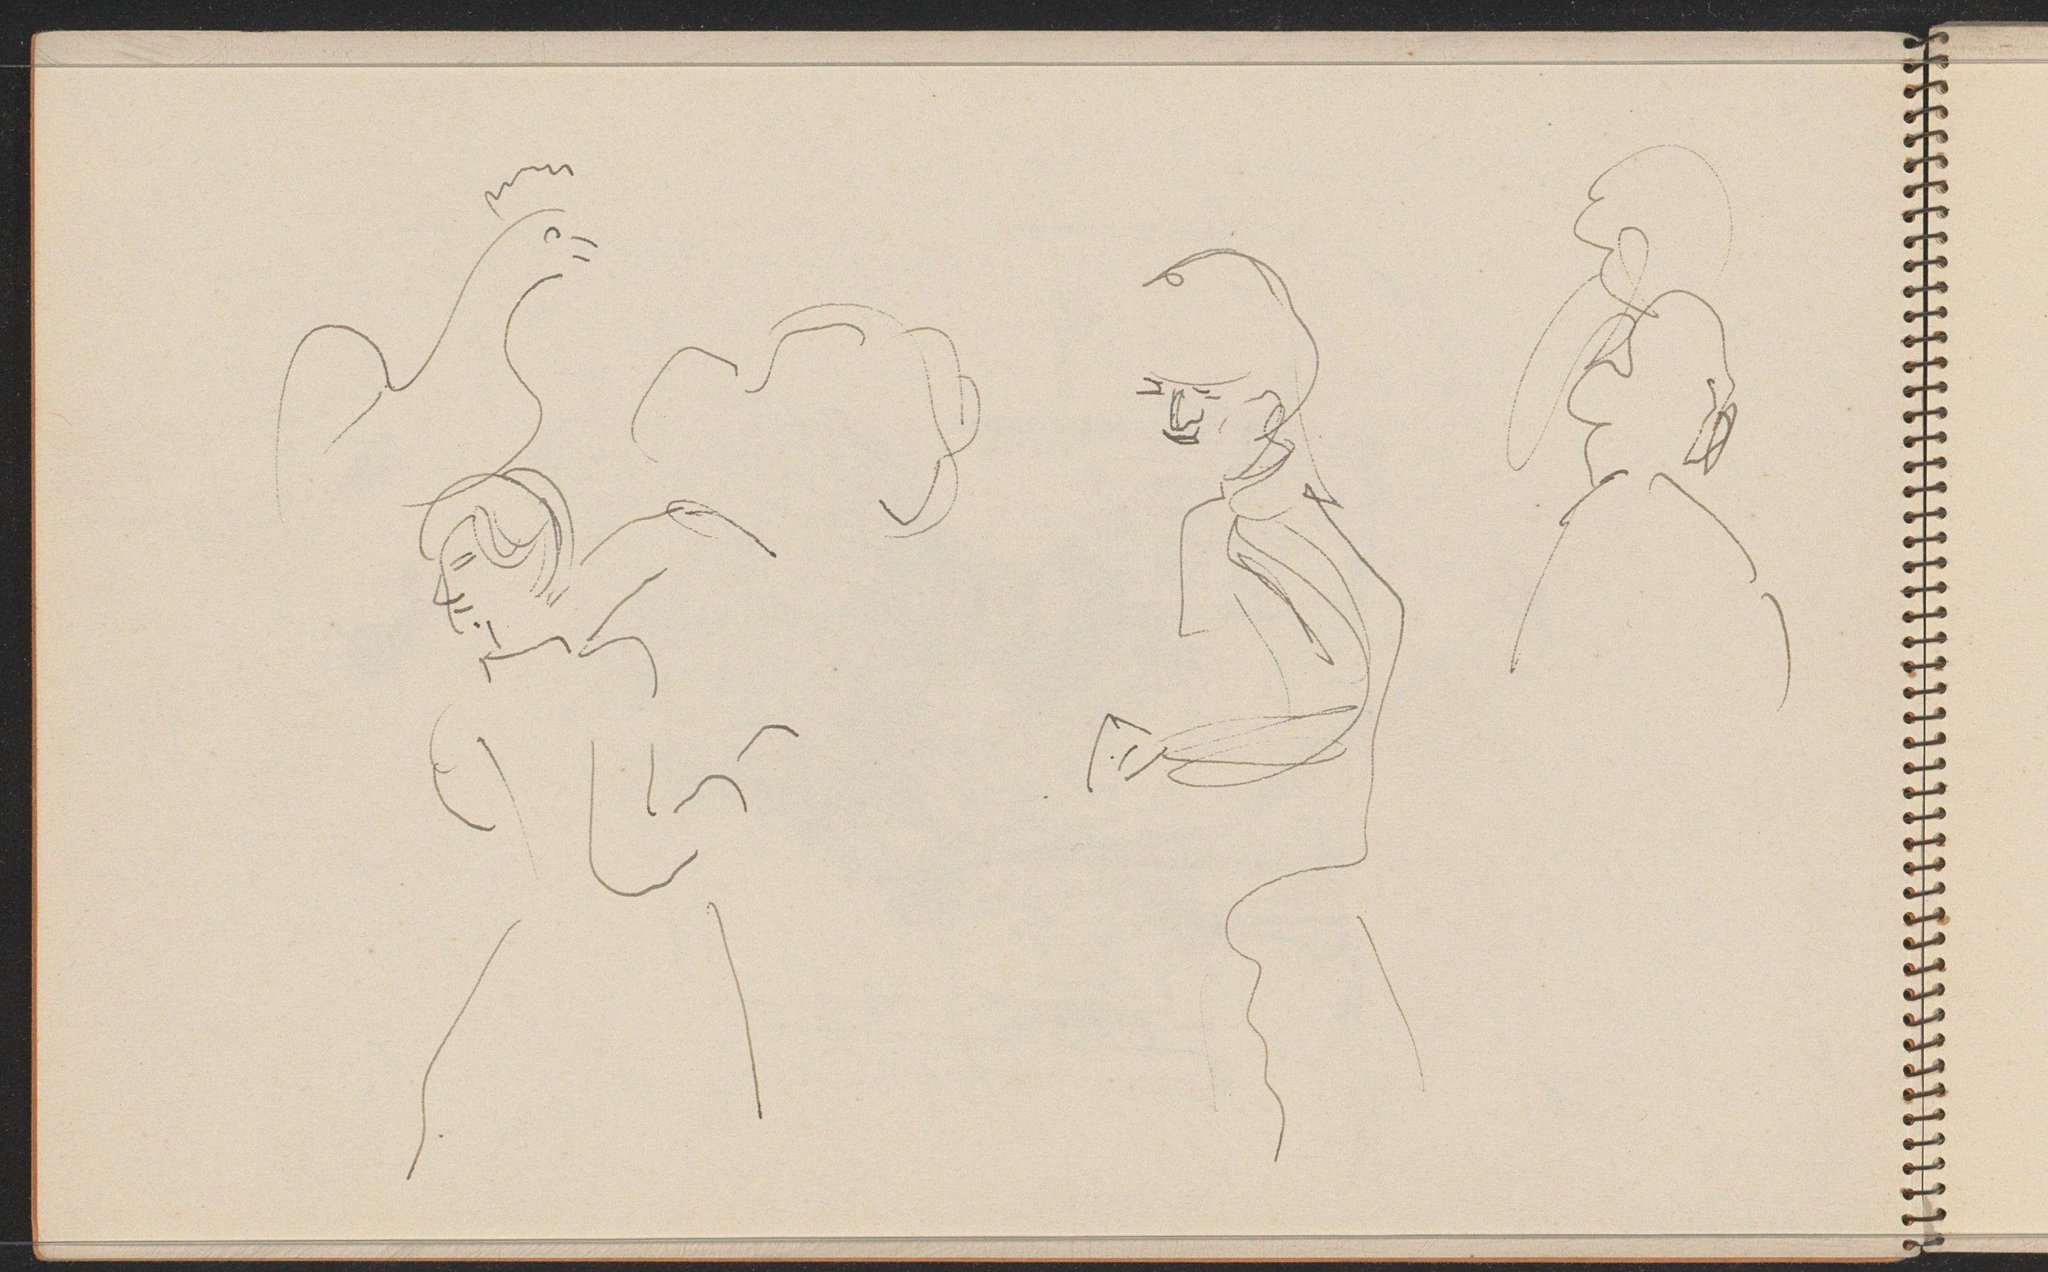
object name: sketchbook leaf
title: Vrouwen en een kip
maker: carel adolph lion cachet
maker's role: draughtsman, print maker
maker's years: 1864-1945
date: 1935-1940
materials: ink, paper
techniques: pen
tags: adult woman, fowl (cock, hen, chicken, etc.)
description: Blad 1 verso uit een schetsboek met 25 bladen.